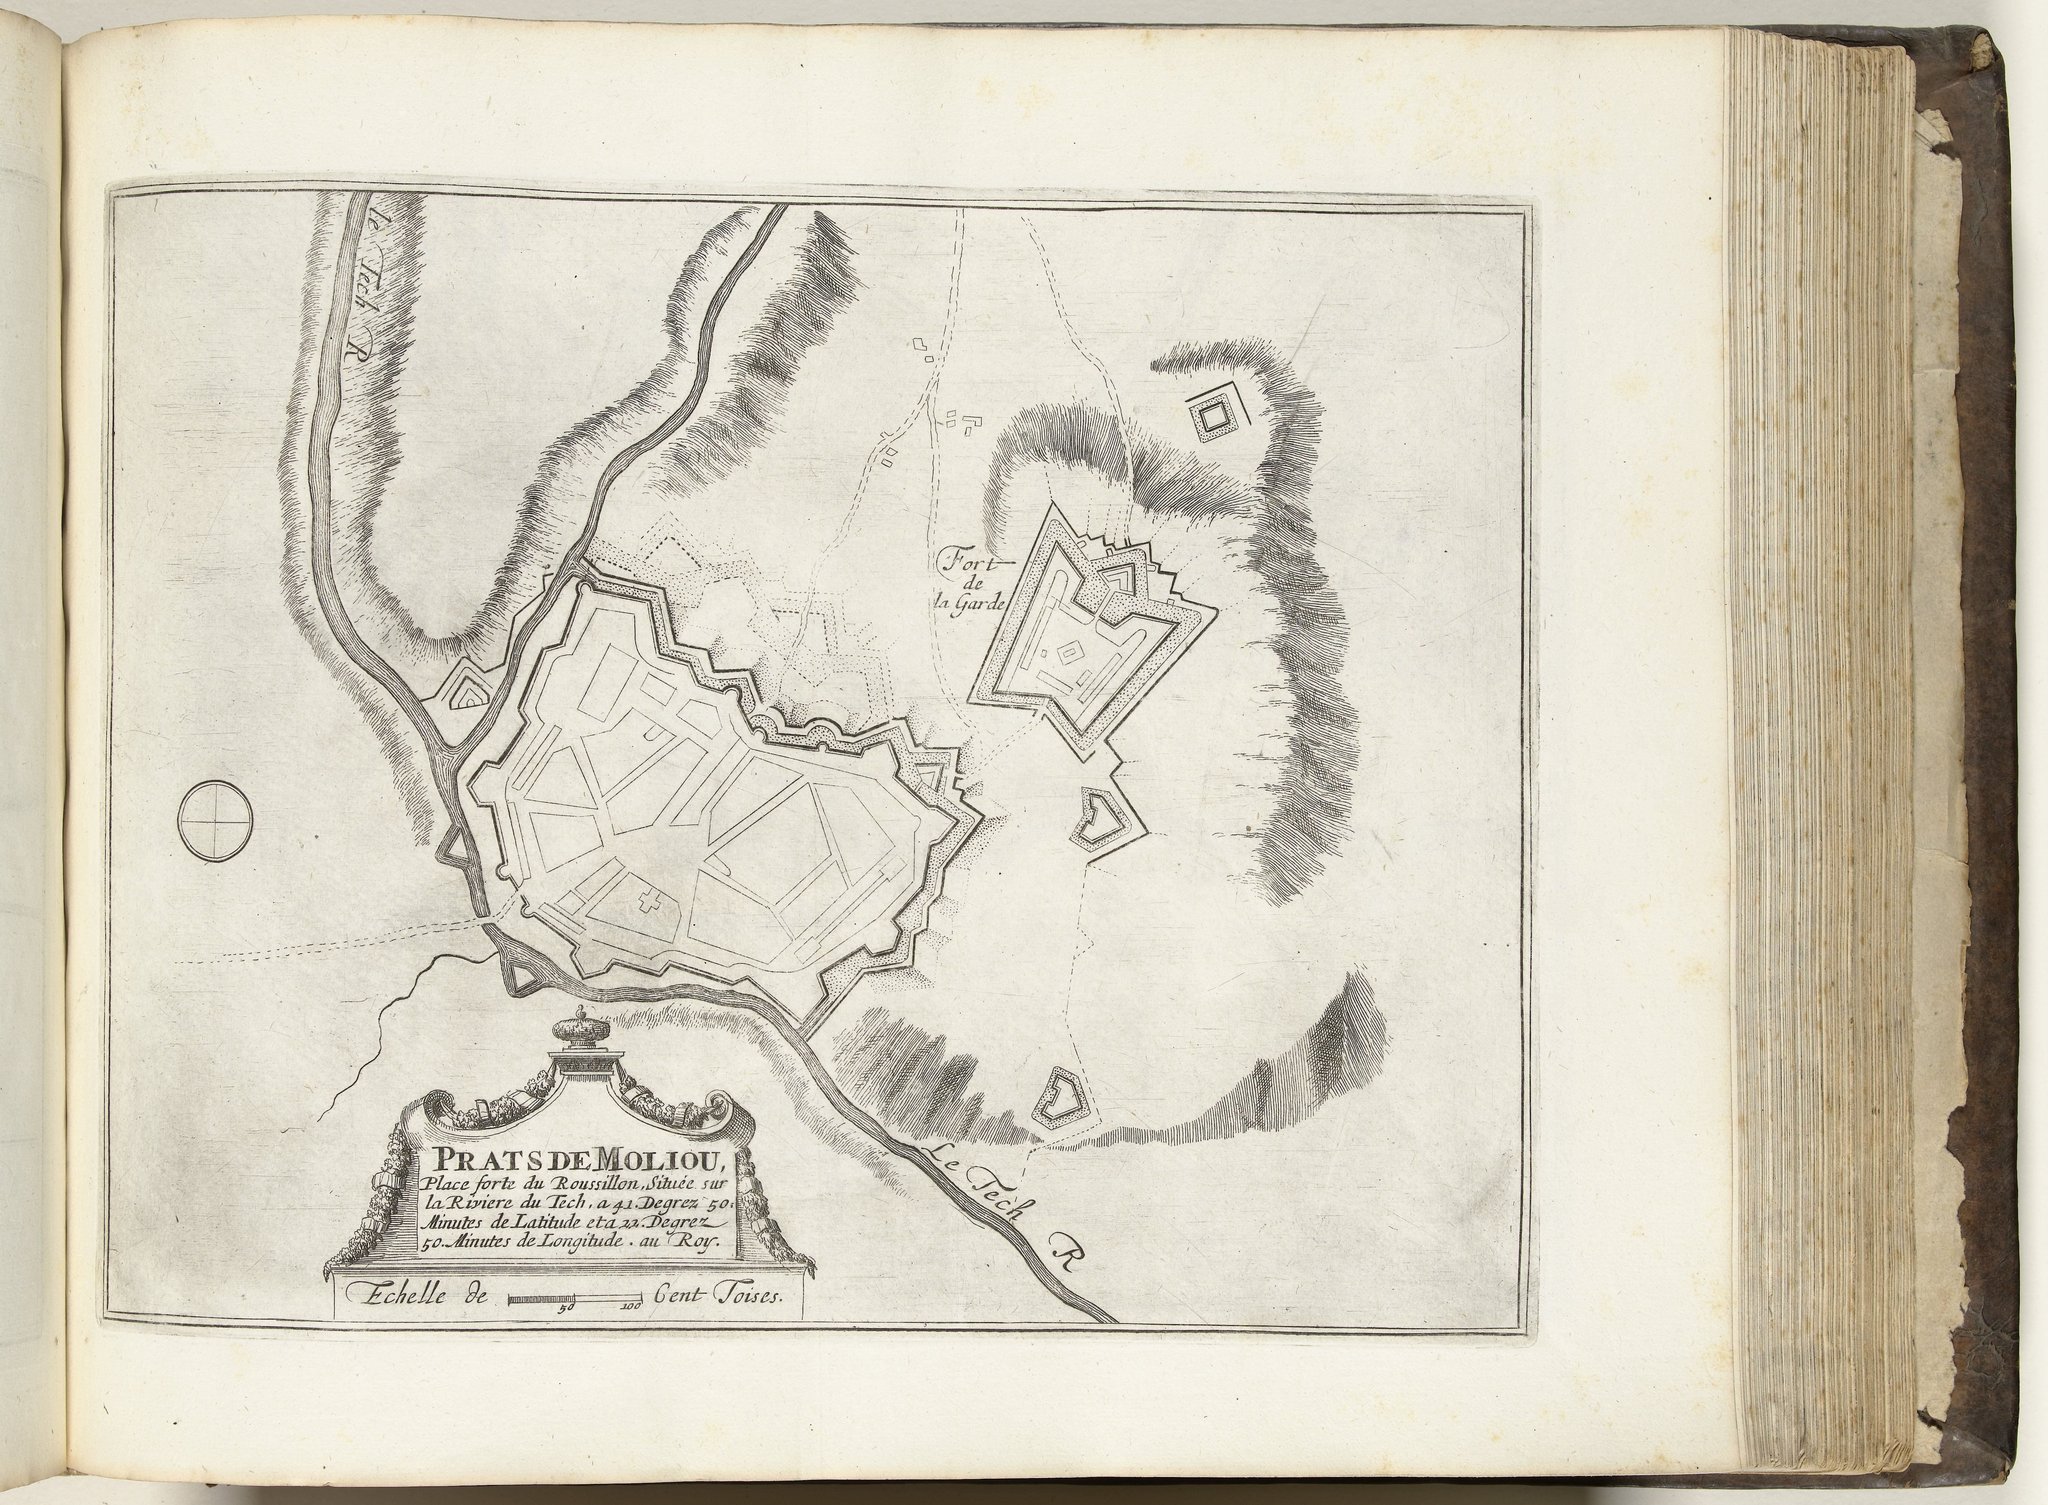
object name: print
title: Plattegrond van Prats-de-Mollo-la-Preste, ca. 1693-1696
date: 1693-1696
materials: paper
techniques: etching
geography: paris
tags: fortress, maps of cities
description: Plattegrond van de versterkingen om de Franse stad Prats-de-Mollo-la-Preste. Onderdeel van het zesde deel (1696) van het prentwerk waarin gebundeld zijn de acht delen van Les forces de l'Europe uitgegeven tussen 1693-1697. Het prentwerk bestaat uit 175 platen met plannen (afkomstig van Sébastien Le Prestre, Seigneur de Vauban) van vermaarde sterke steden en vestingen in de Negenjarige Oorlog. Titel en opschriften in het Frans.